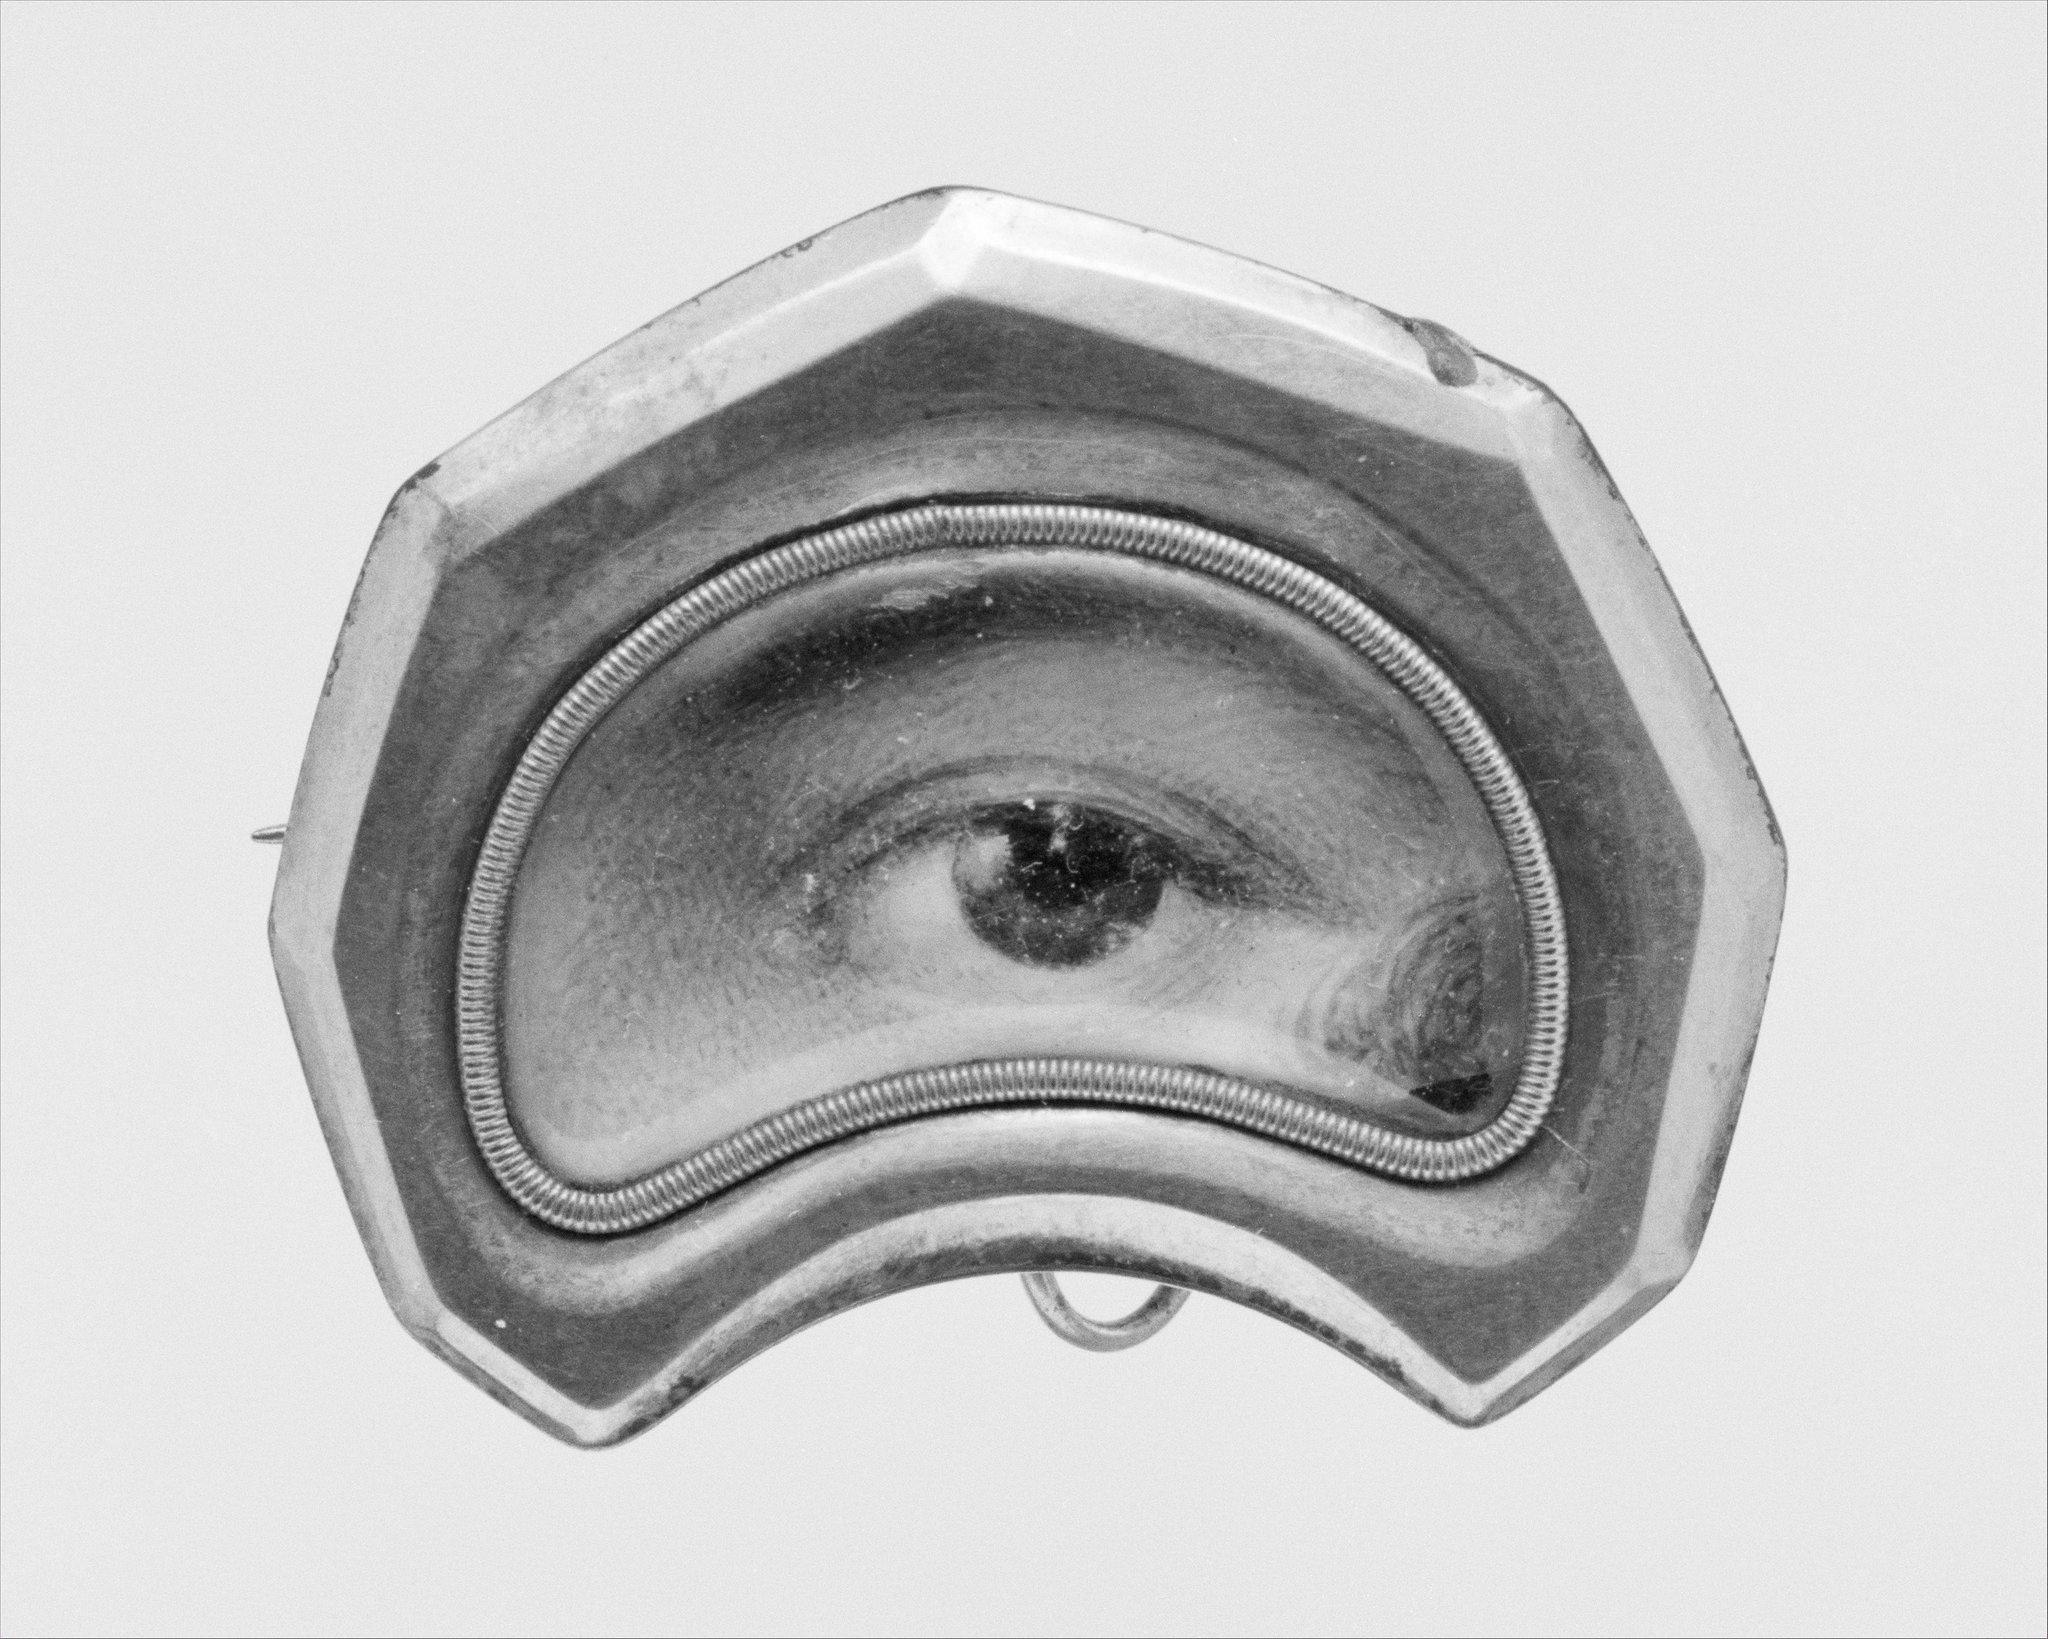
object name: painting, miniature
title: Eye Miniature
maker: british painter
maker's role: artist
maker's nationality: british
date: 1800-1829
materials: ivory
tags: eyes